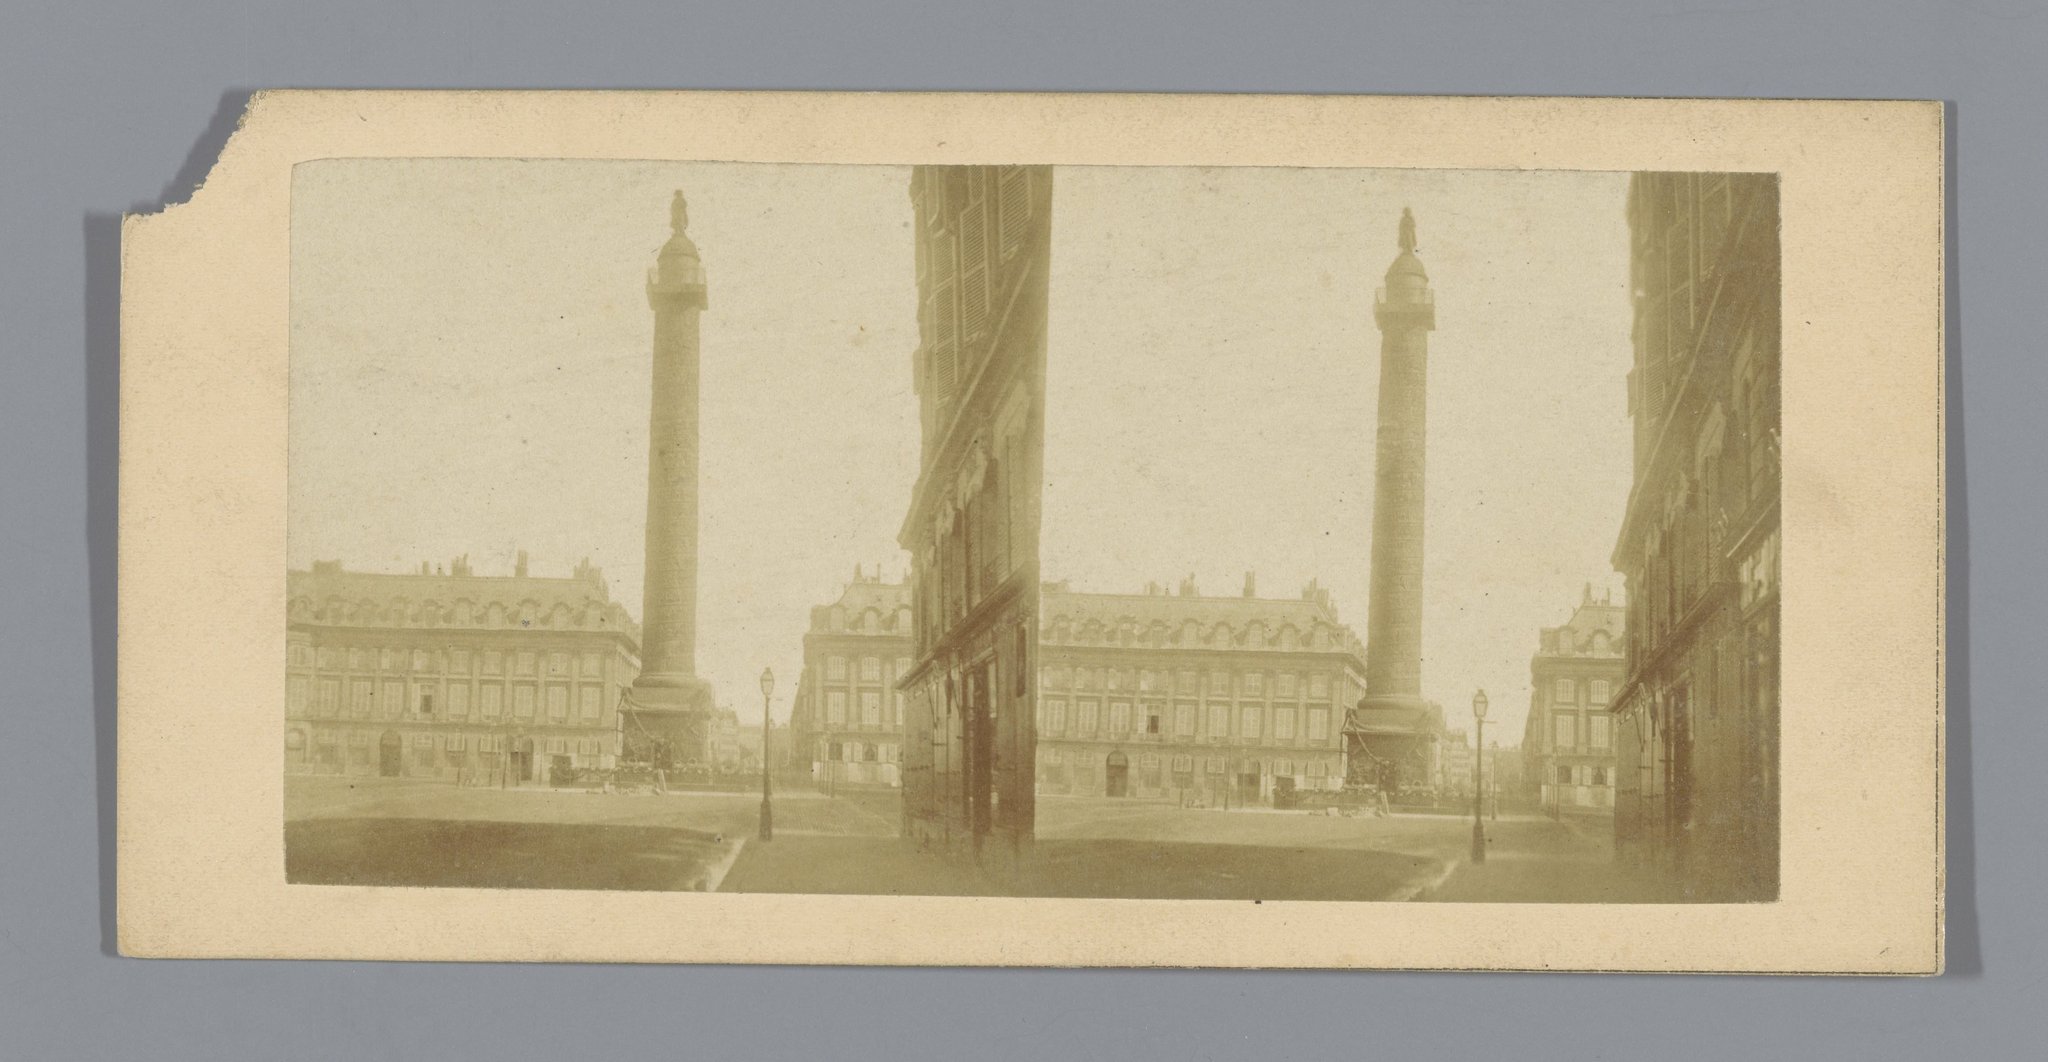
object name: stereograph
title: Colonne Vendôme te Parijs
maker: Anonymous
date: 1860-1885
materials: cardboard, photographic support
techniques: albumen print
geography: place vendôme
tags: square, place, circus, etc., triumphal column with helical friezes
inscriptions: number: ‘No 4.’, inscription: ‘Colonne Vendome’